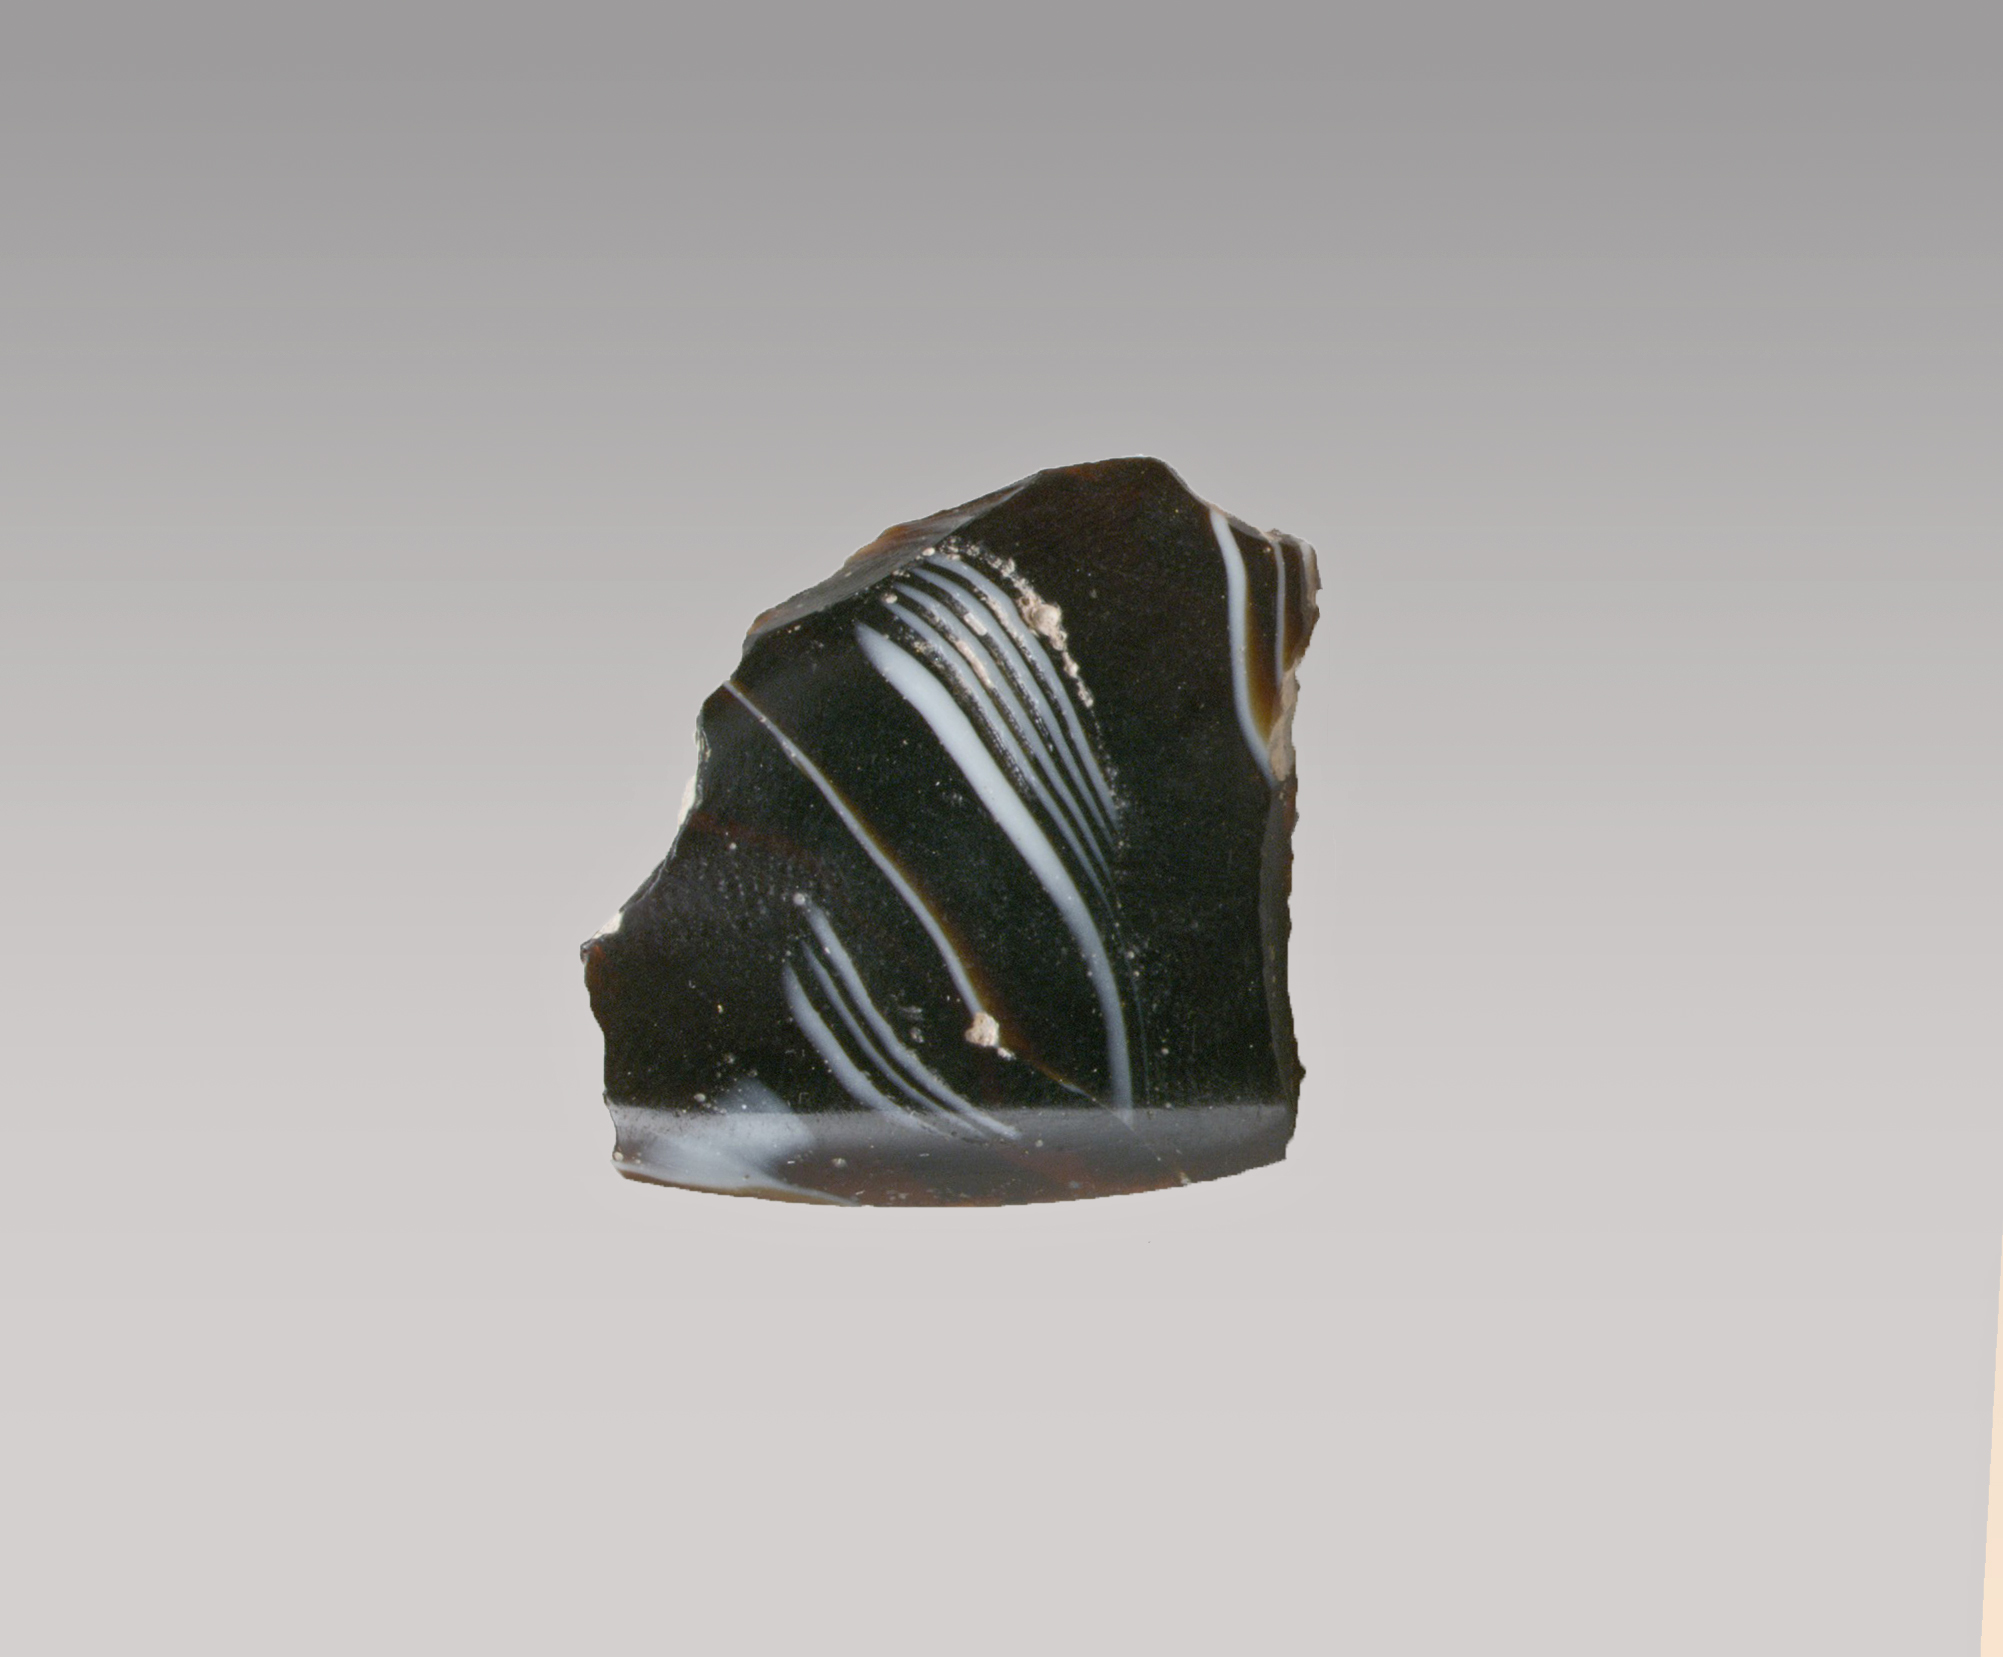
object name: fragment, mosaic base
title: Glass mosaic fragment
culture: roman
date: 34 BCE-33 CE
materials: glass